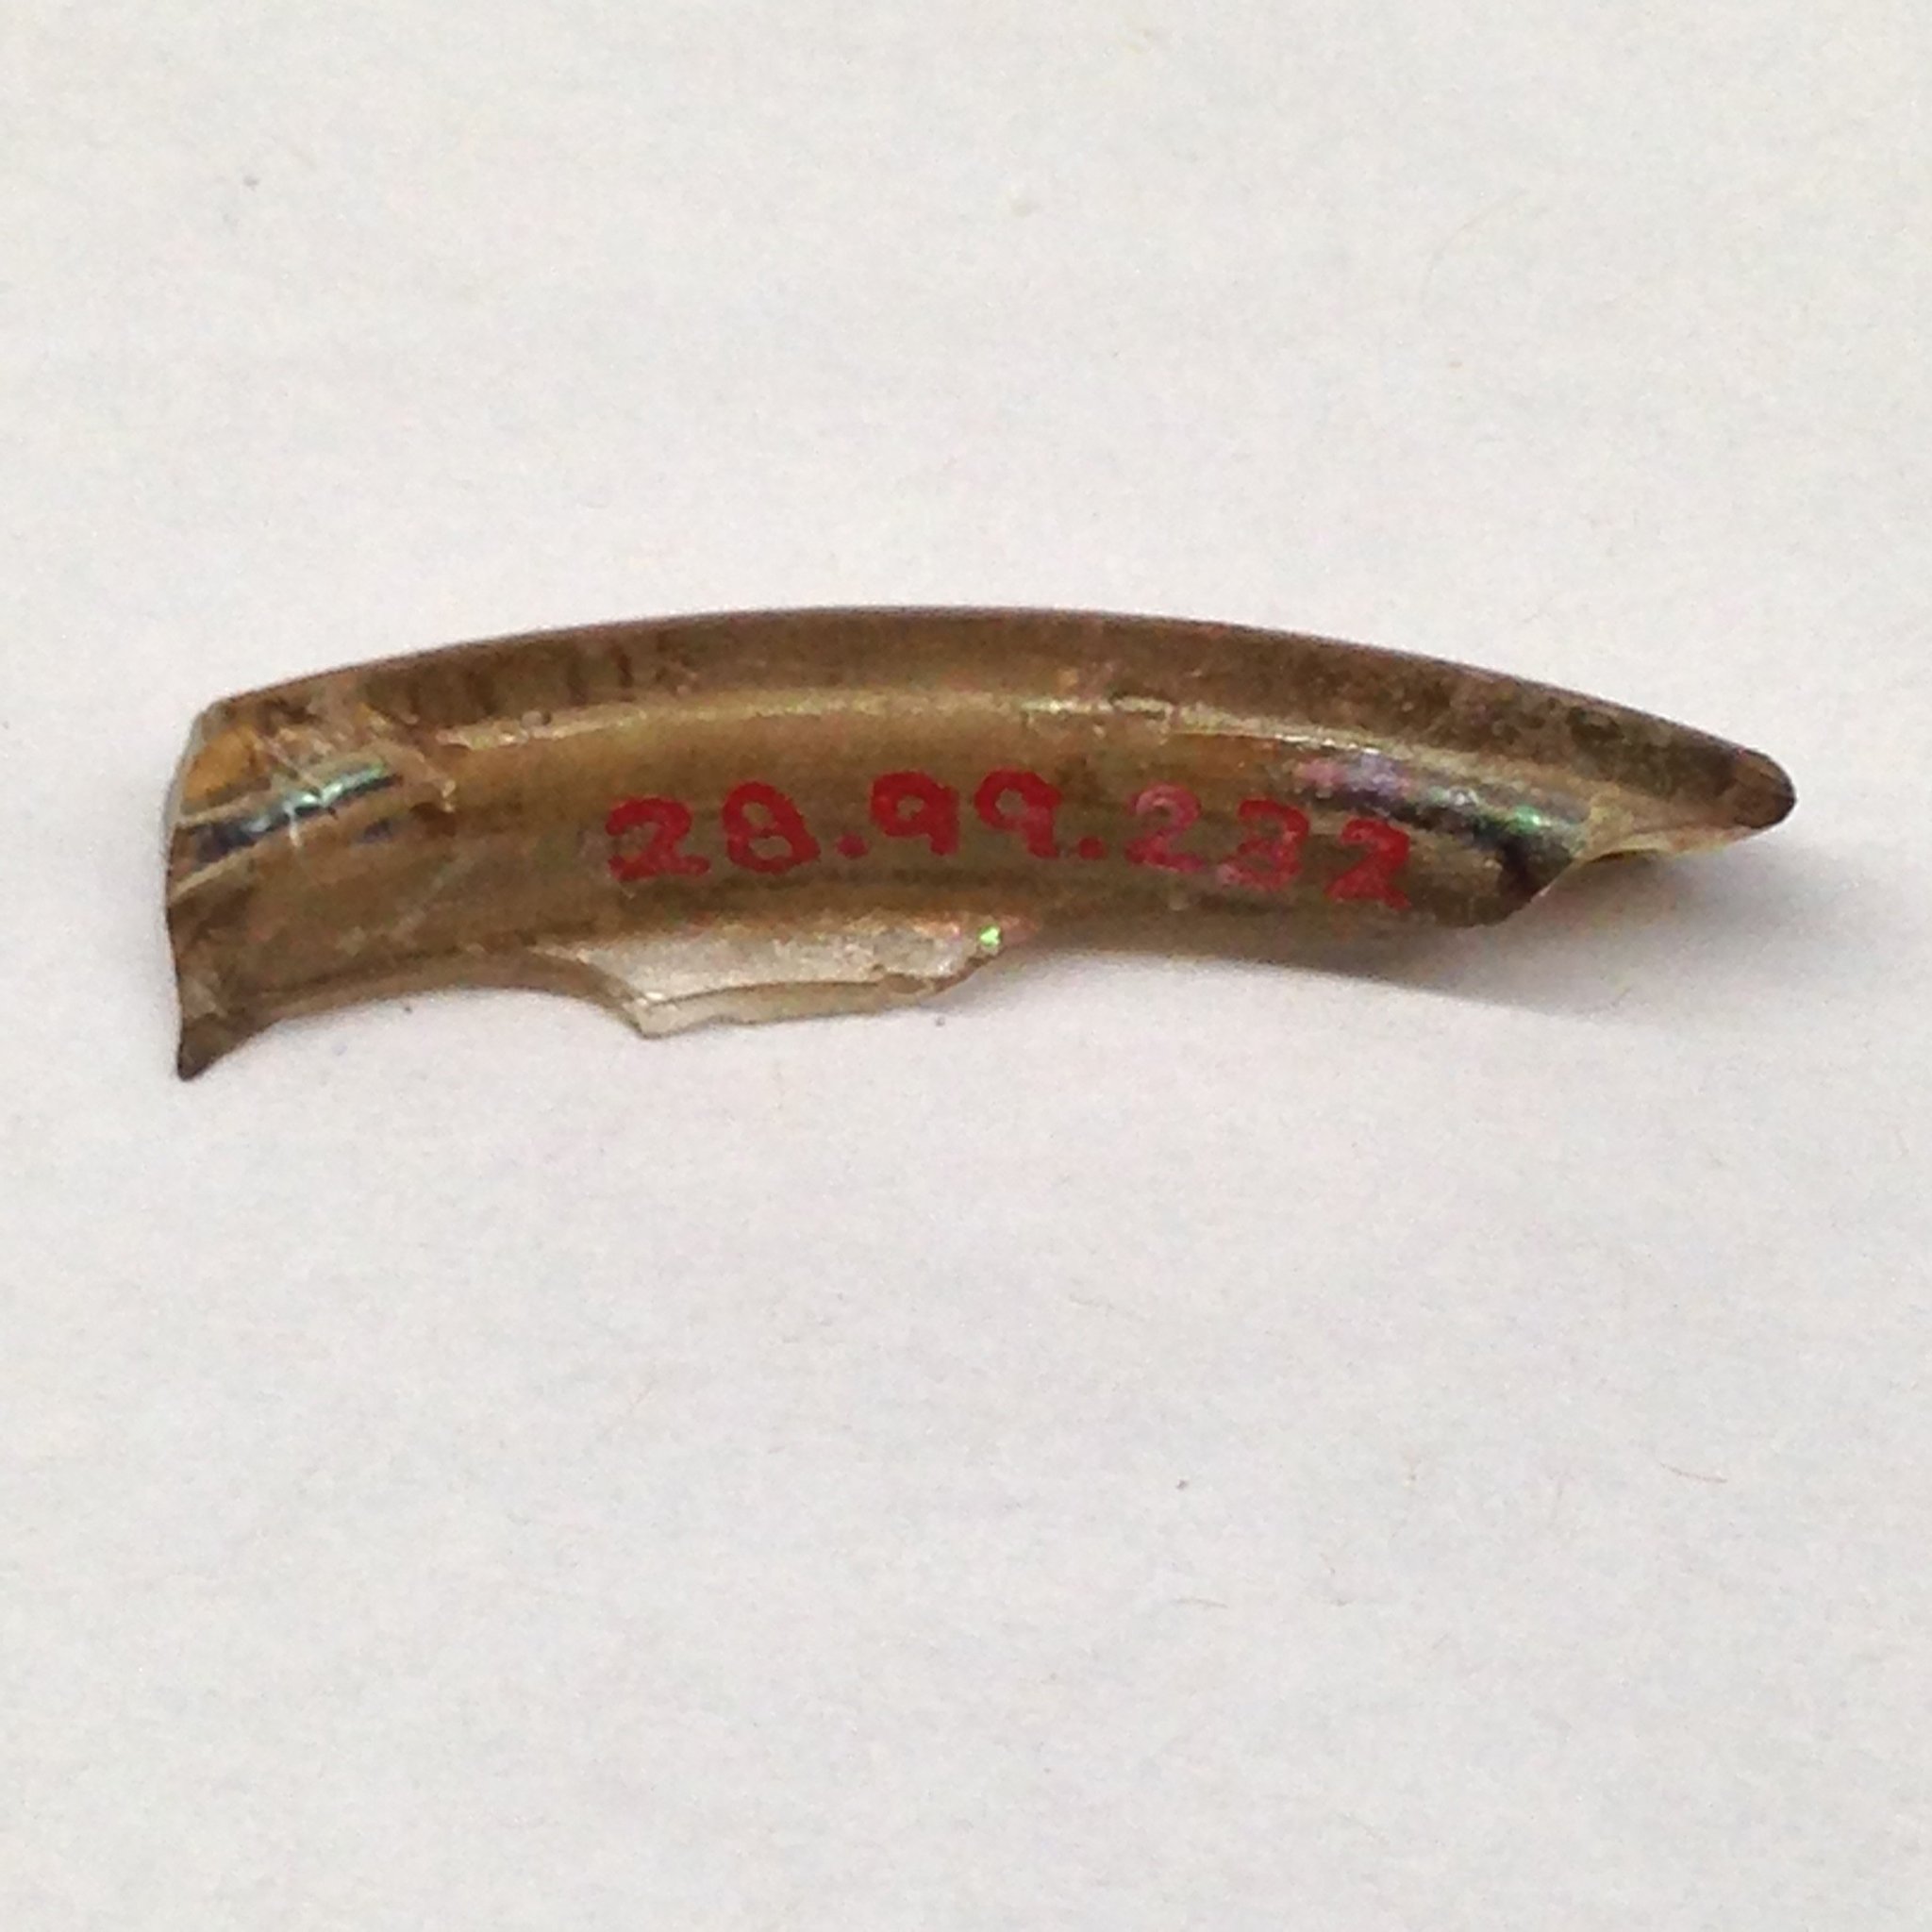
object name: fragment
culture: european or middle eastern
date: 1150-1250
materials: ceramic, glass